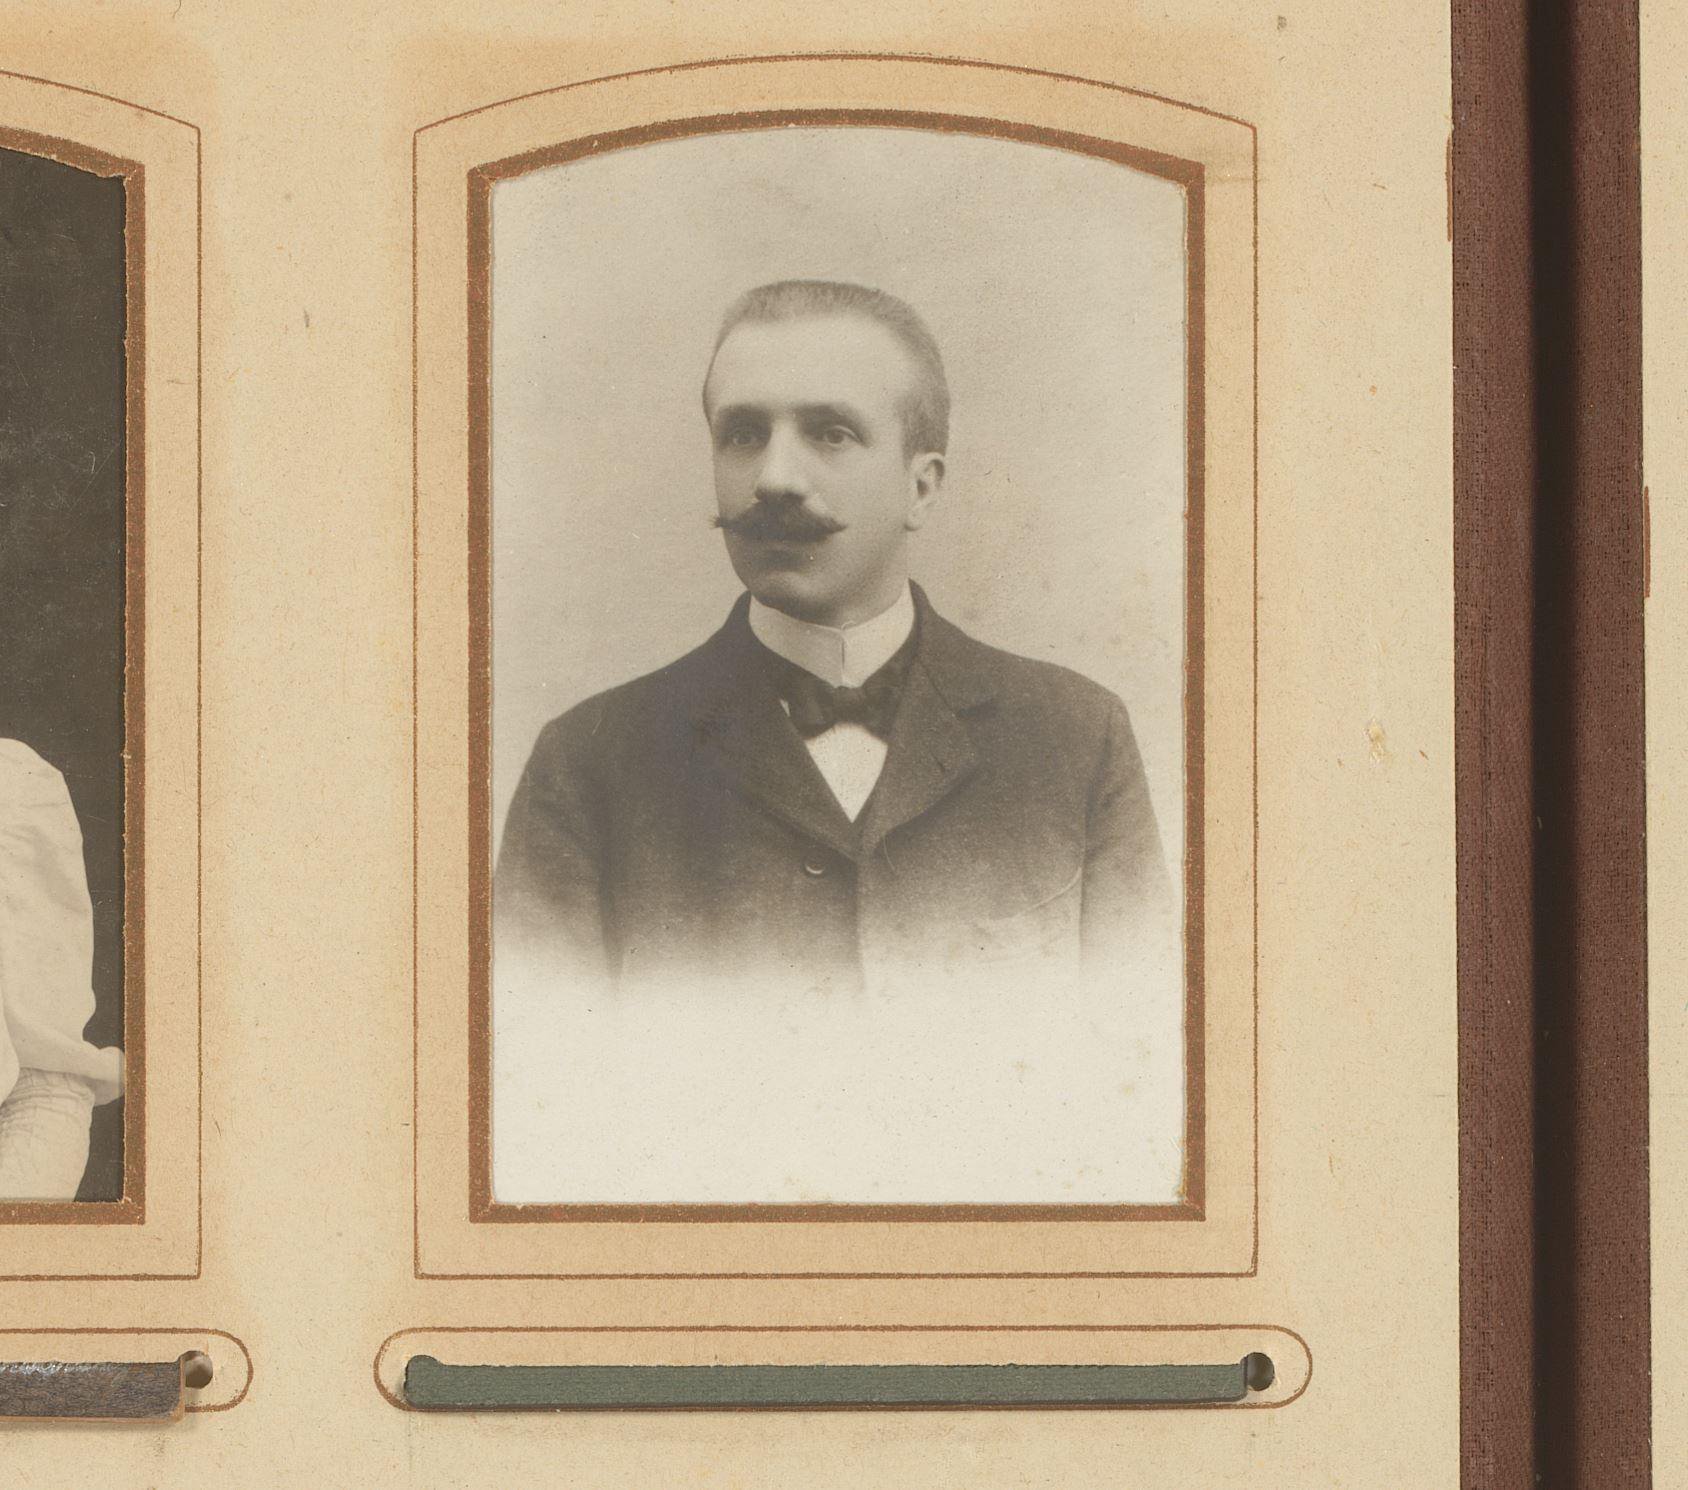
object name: album leaf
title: Portret van een man met snor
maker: Anonymous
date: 1890-1920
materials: cardboard, photographic support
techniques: collodion silver print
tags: moustache, historical persons